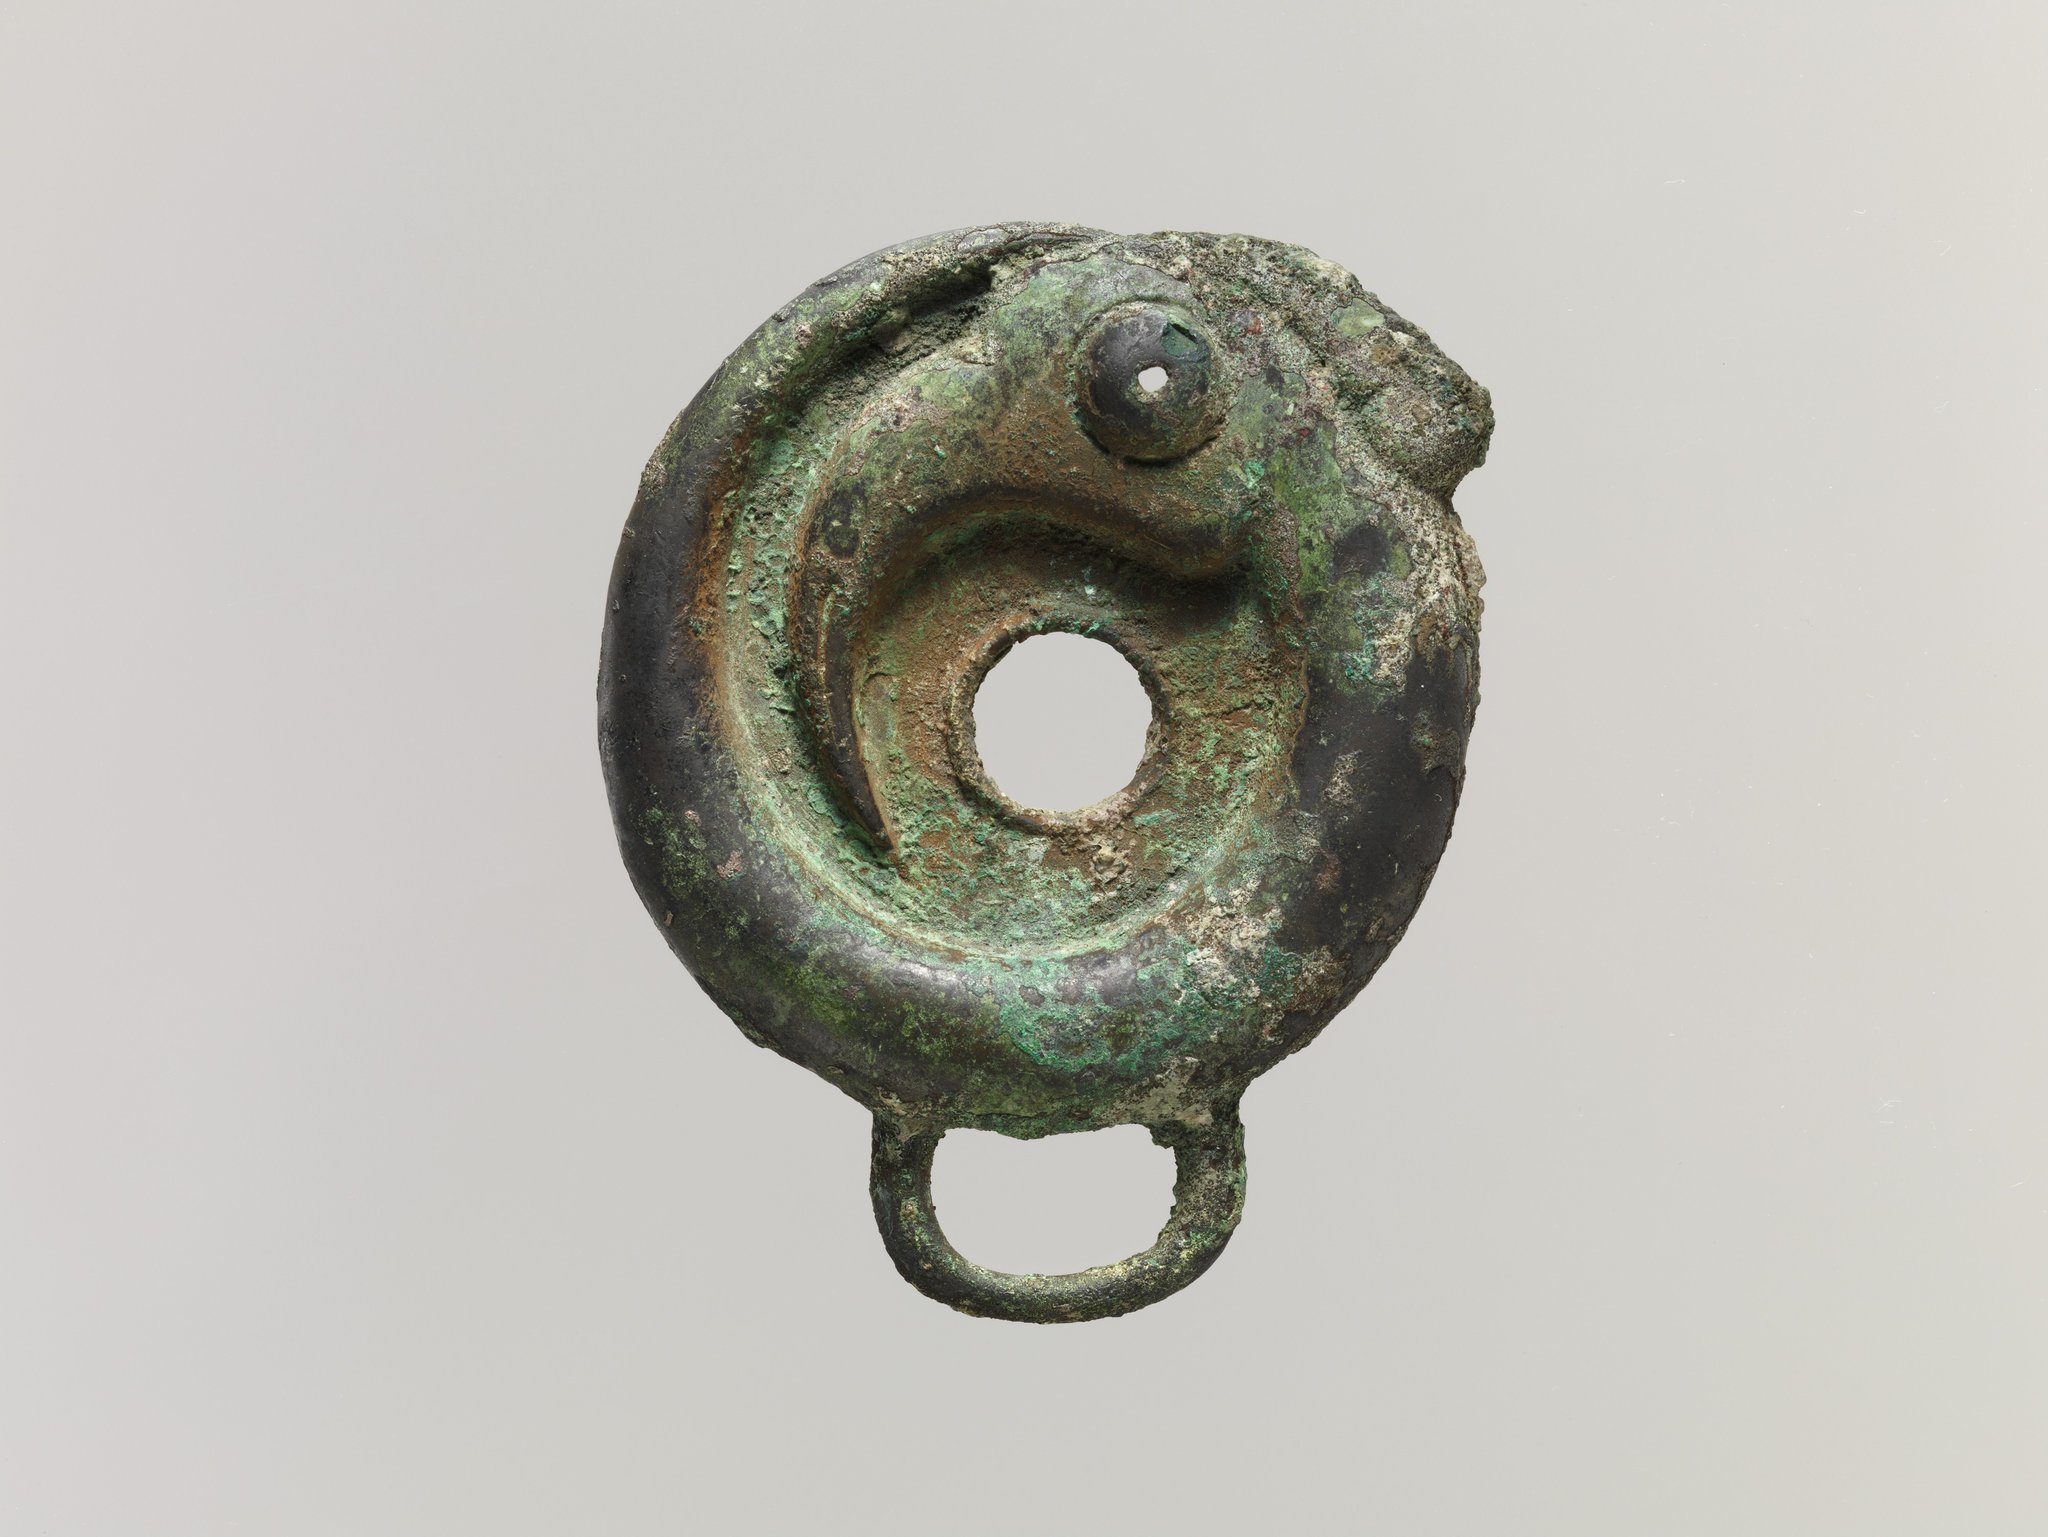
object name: bridle cheekpiece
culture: chinese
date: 1000-801 BCE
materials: bronze